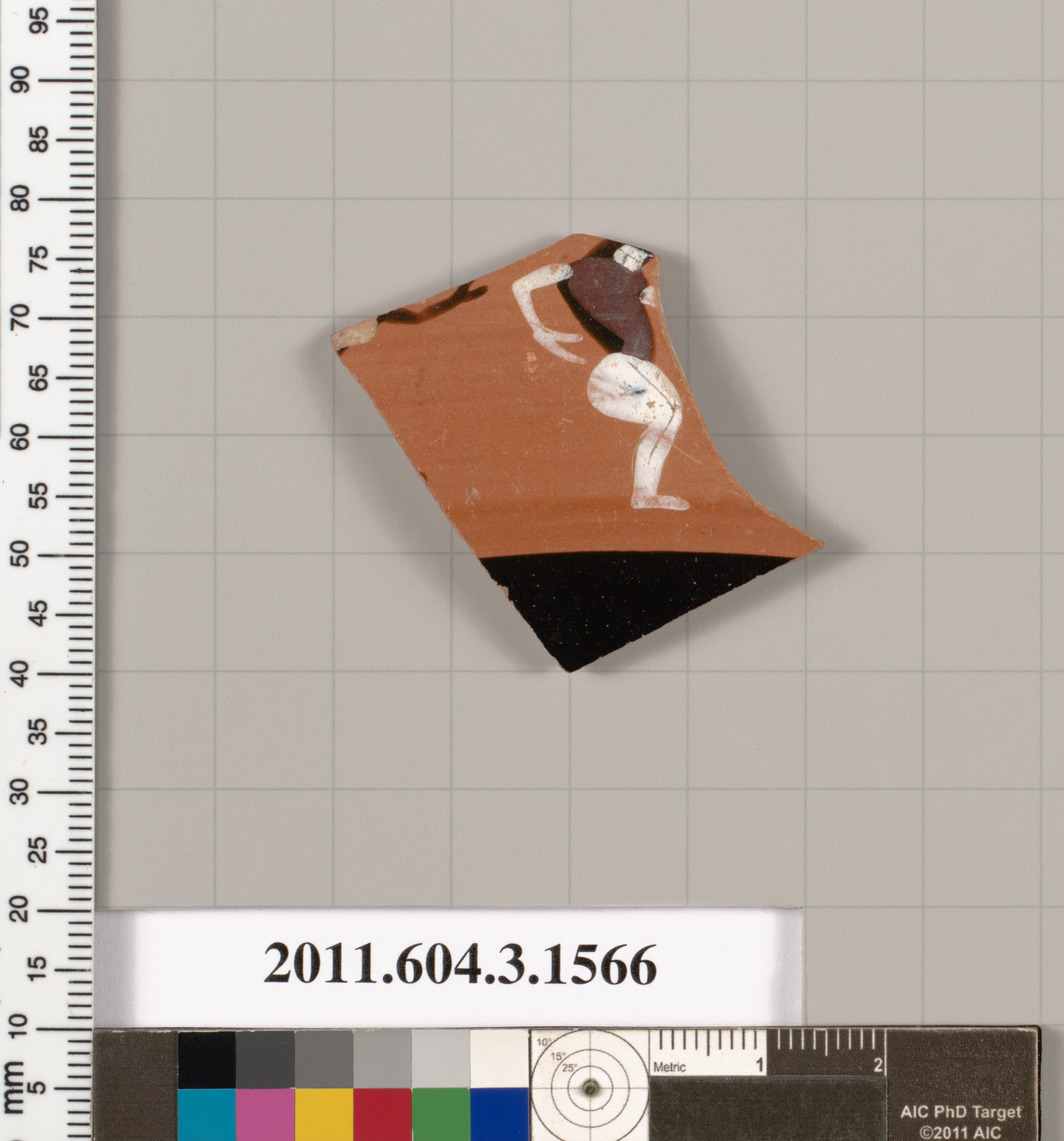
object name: kylix fragment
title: Terracotta fragment of a kylix: Band cup (drinking cup)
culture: greek, attic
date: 550-526 BCE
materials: terracotta